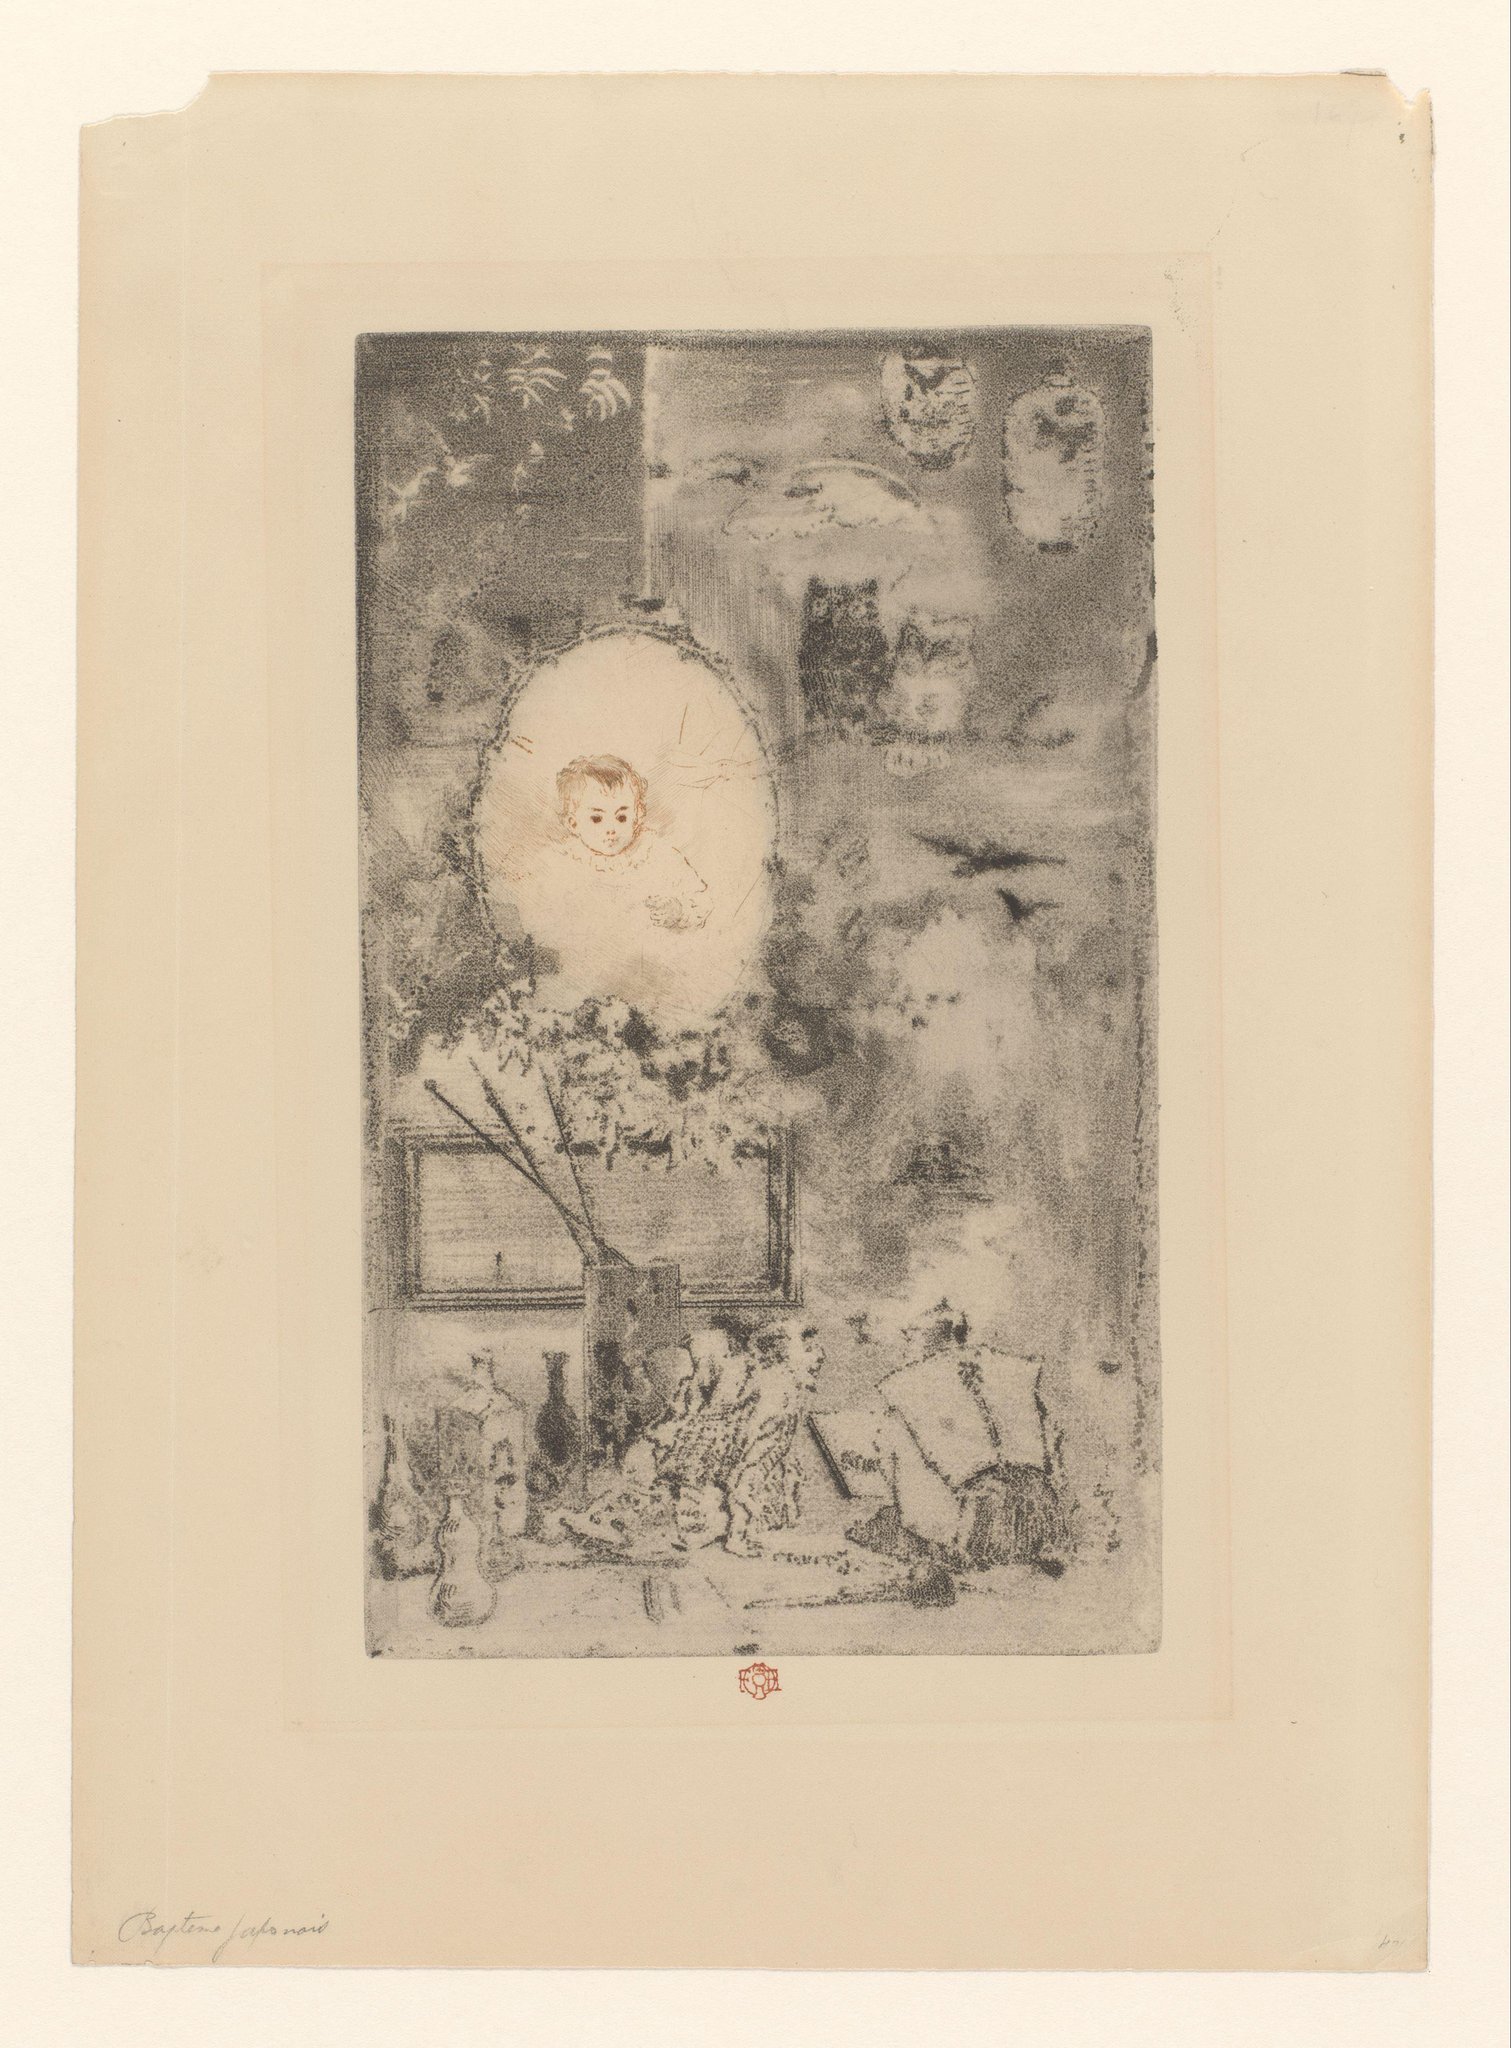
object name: print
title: Portret van een baby in een ovaal boven een tafel met wierook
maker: félix hilaire buhot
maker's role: draughtsman, print maker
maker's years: 1847-1898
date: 1887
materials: paper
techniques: aquatint, drypoint, etching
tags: owls, incense-burner ~ scents, perfumes, infant, baby, historical persons (portraits and scenes from the life)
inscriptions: collector's mark: Lugt 2228, stamp: Lugt 978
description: Portret van een baby in een ovaal, omringd door een tak met twee uilen, lampionnen en een schilderij, boven een tafel met wierook, flessen en twee Japanse beeldjes.